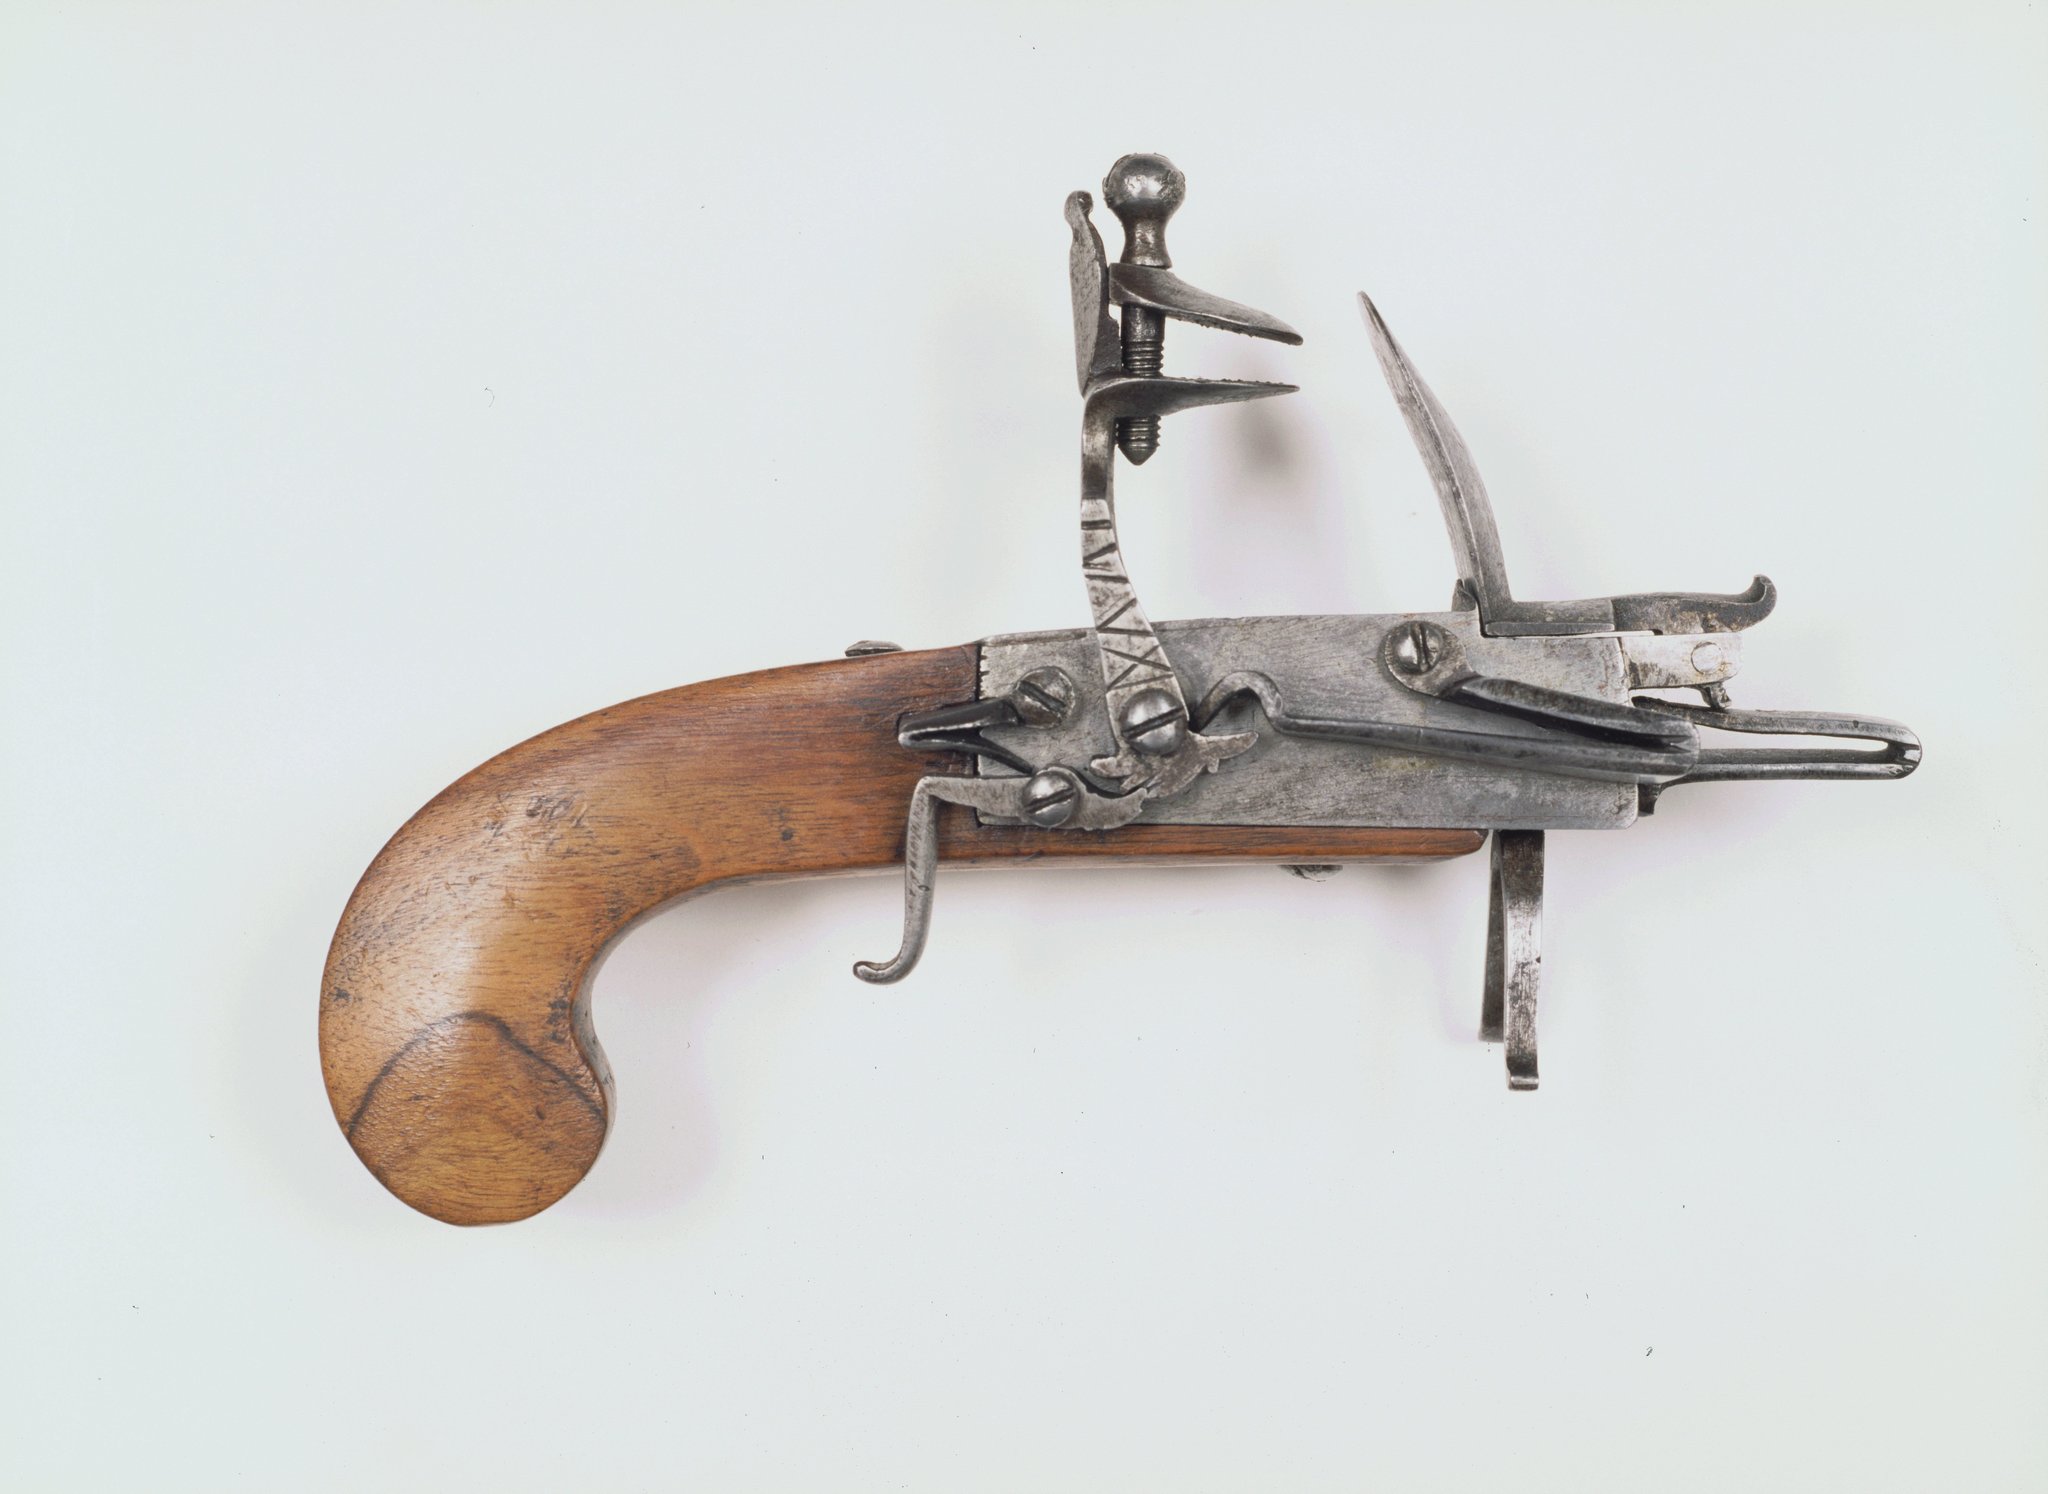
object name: tinder box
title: Pistool-tondeldoos met vuursteenslot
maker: Anonymous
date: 1750-1825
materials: iron, wood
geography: western europe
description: Tondeldoos met vierkant ijzeren gedeelte, aan de voorkant een bakje voor de zwam en deksel met aanslagvlak en veer. Aan de linkerkant van het bakje een koker voor de lont. Aan de rechterkant van het vierkante gedeelte zijn de spanveer voor de haan, welke aan de rechterkant draaiend, naar links is omgebogen en zich aldus met de vuursteen in het midden van de bovenkant bevindt; trekker met trekkerveer. Aan de voorkant een ijzeren vork voor steun. Geheel blank. Notenhouten kolf van Engels pistoolkolfmodel. Mechanisch functionerend.